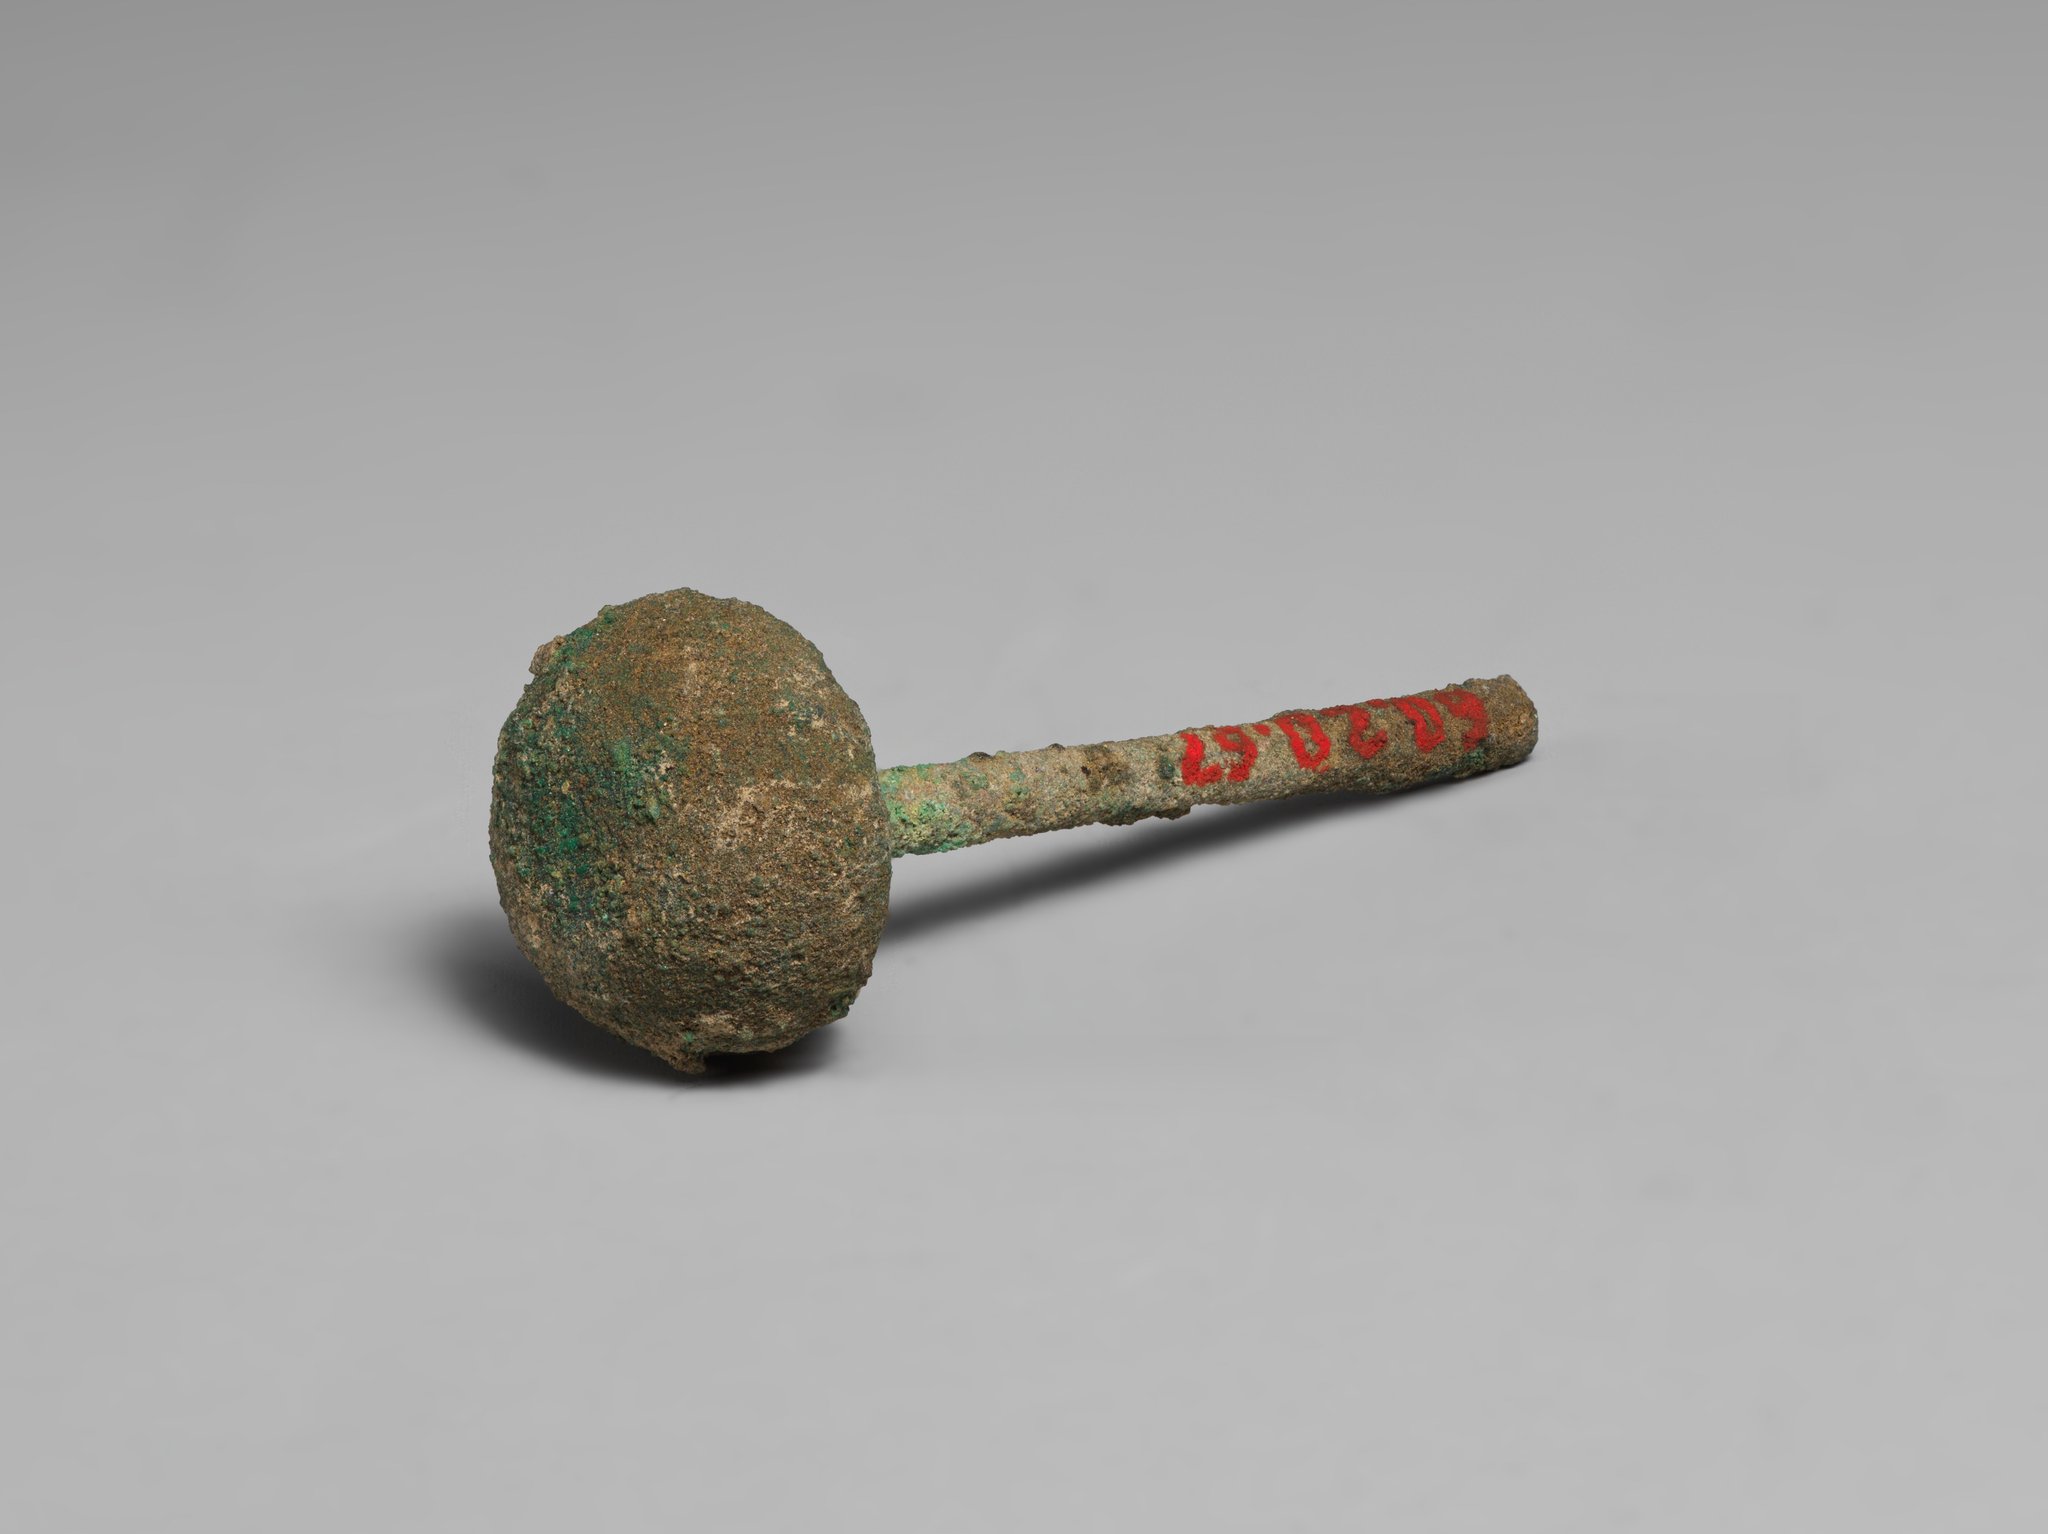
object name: stud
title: Studs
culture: iranian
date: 900-801 BCE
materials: bronze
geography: iran